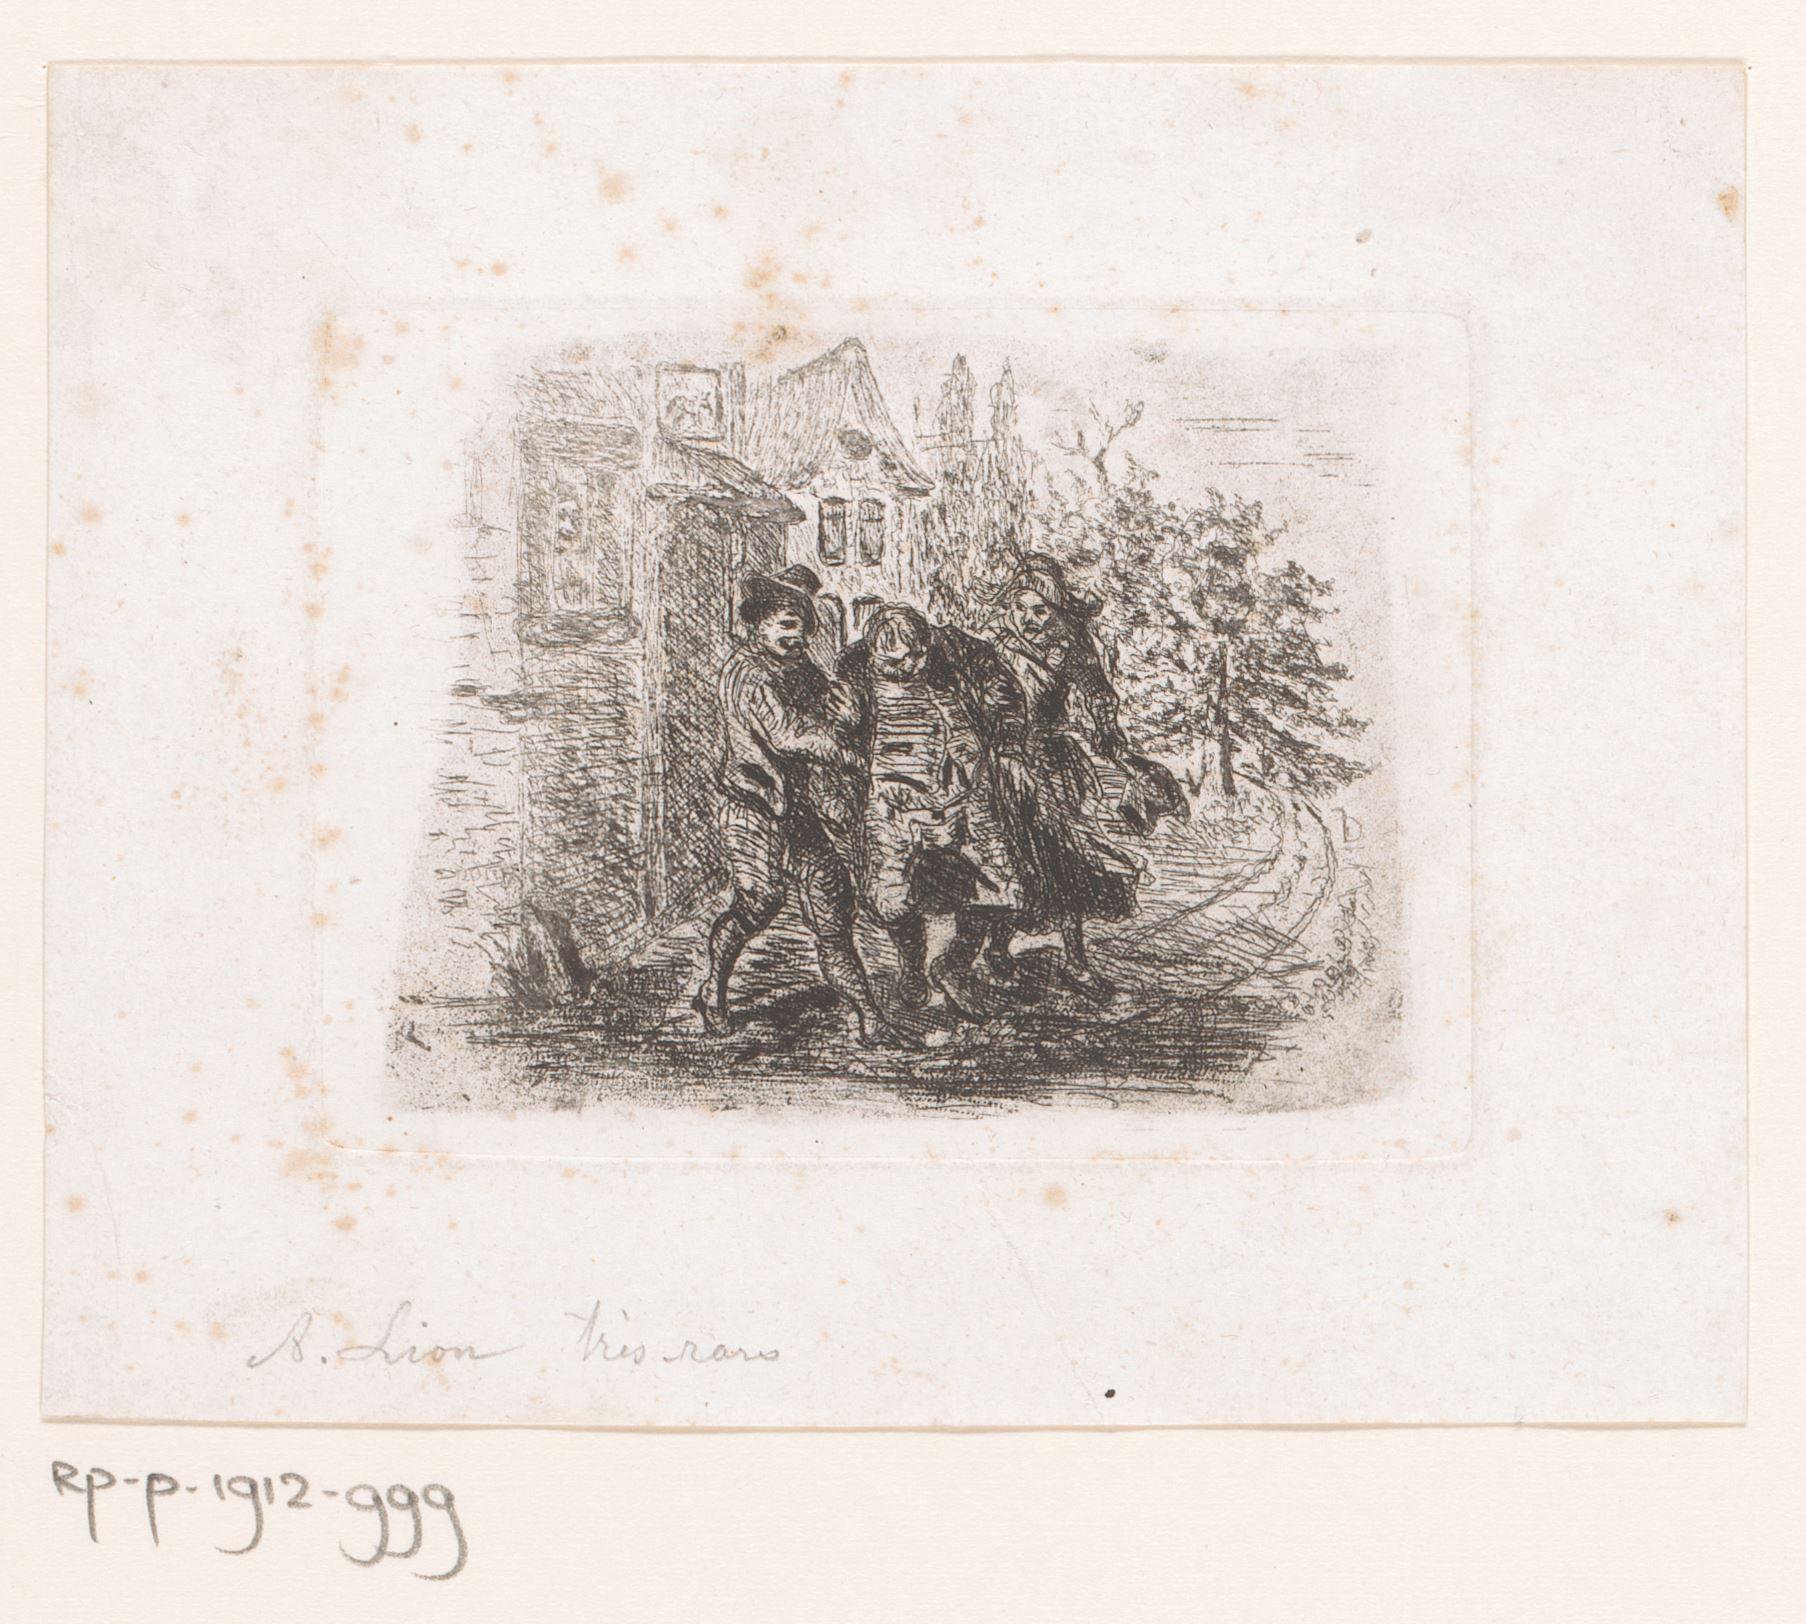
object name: print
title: Dronken man wordt door een man en vrouw over straat geholpen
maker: alexandre louis lion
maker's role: print maker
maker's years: 1823-1852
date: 1833-1852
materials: paper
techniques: etching, intaglio, roulette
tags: drunkard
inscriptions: collector's mark: Lugt 2228, collector's mark: Lugt 1485